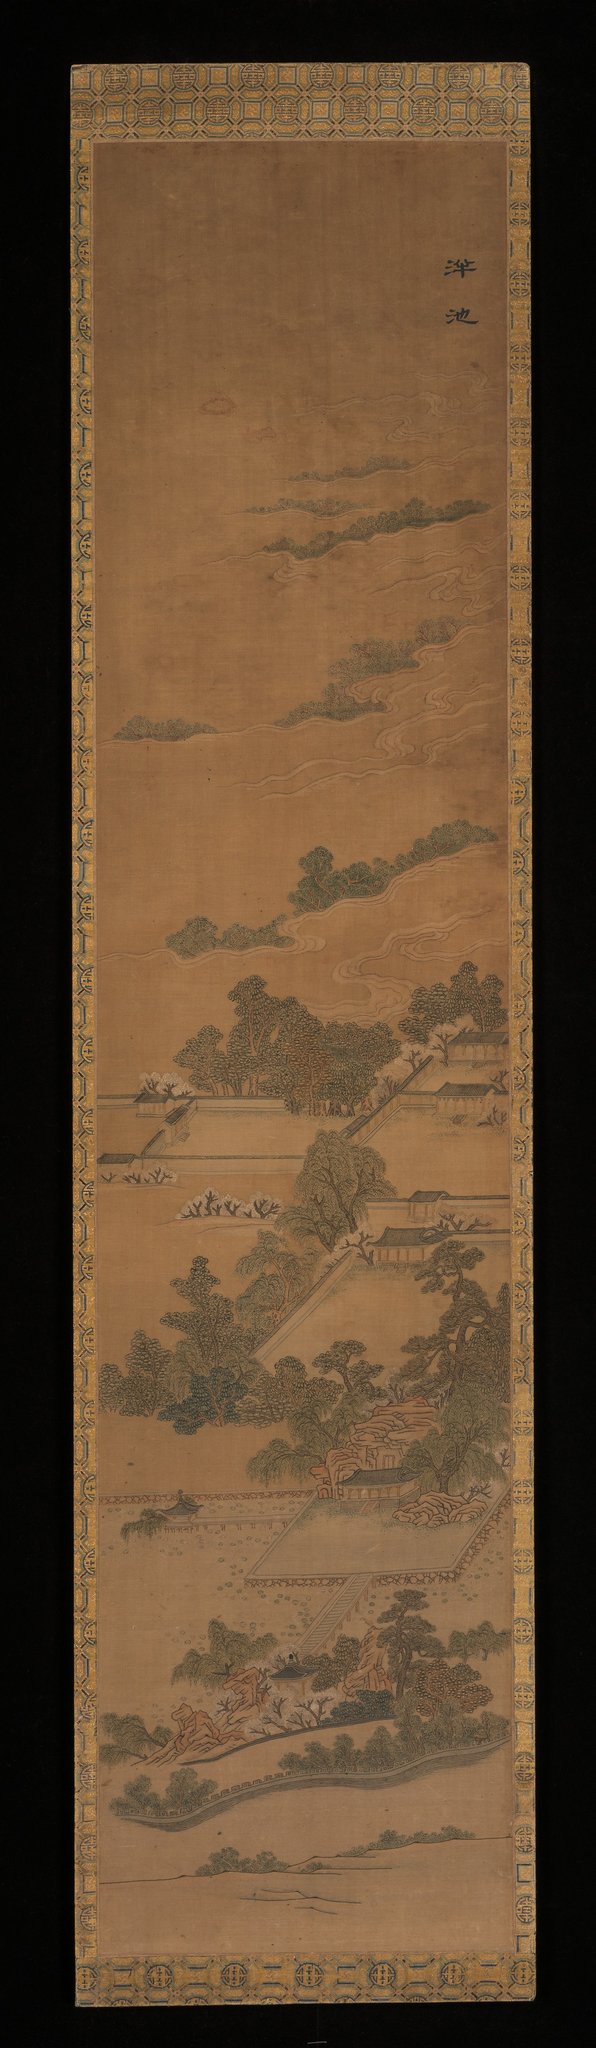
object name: tapestry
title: Scenic Sites in the Qianlong Emperor’s Southern Inspection Tour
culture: chinese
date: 1801-1900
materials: ink, silk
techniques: tapestry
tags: landscapes